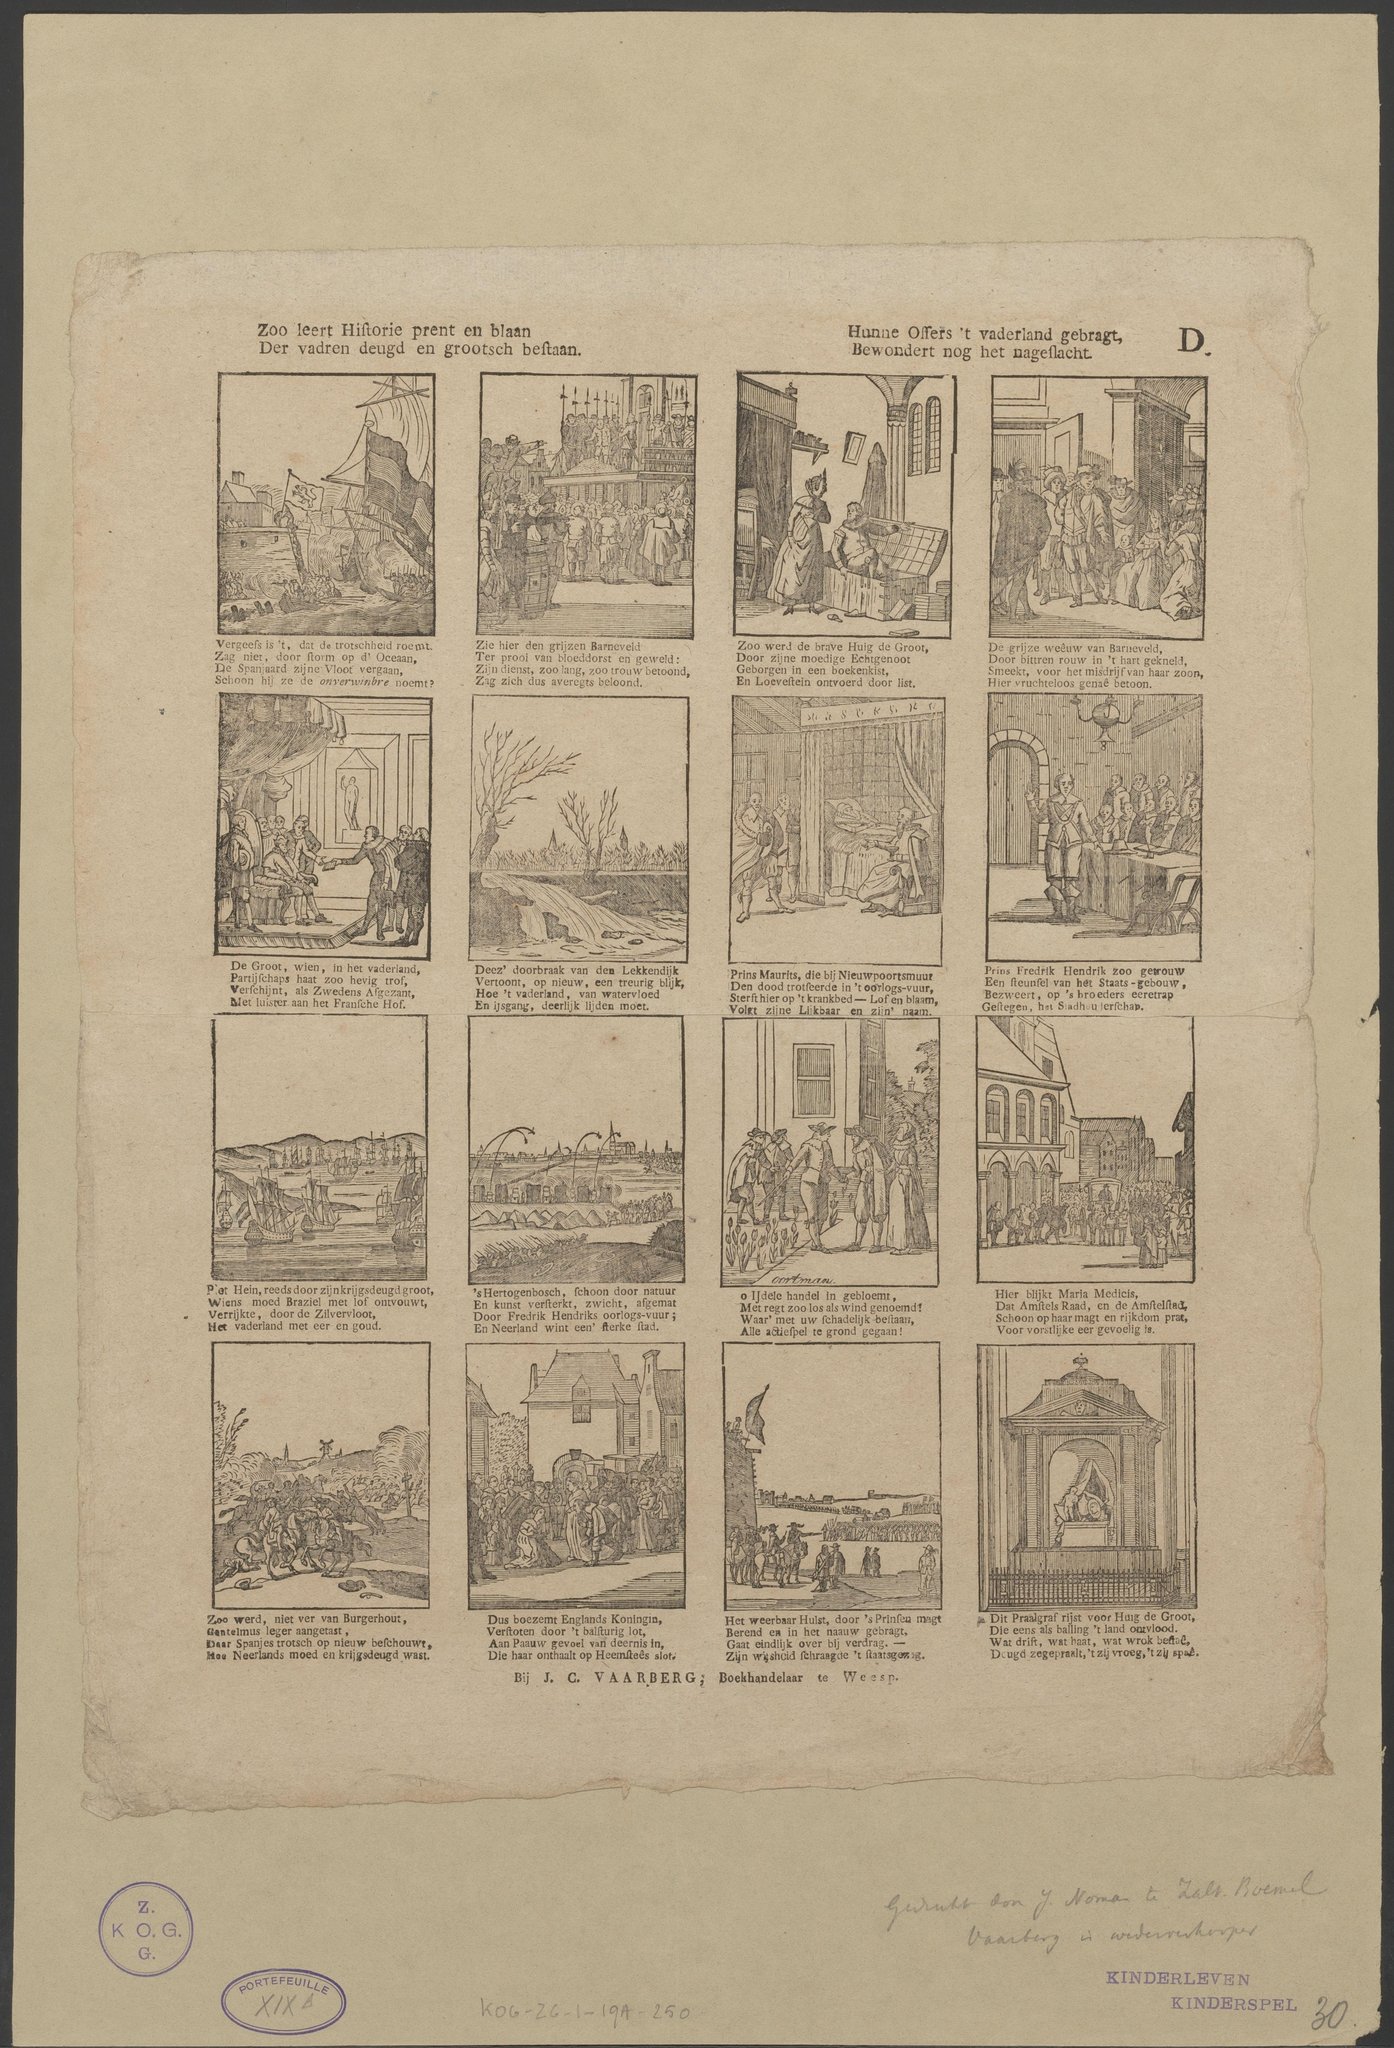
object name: popular print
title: Gebeurtenissen uit de vaderlandse geschiedenis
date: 1806-1830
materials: paper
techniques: letterpress printing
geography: weesp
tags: delft, hugo de groot, johan van oldenbarnevelt, delfshaven, frederick henry (prince of orange), the hague, maurice (prince of orange), cologne, print maker, maria de' medici, politics, loevestein castle, den bosch, low countries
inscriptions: stamp, stamp, collector's mark: Lugt 1641, watermark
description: Blad met zestien voorstellingen van gebeurtenissen uit de vaderlandse geschiedenis, zoals Hugo de Groot die ontsnapt uit Slot Loevestein in een boekenkist en de dood van Maurits. Onder elke afbeelding een vierregelig vers. Gemerkt rechtsboven: D. Onderwerpsrubrieken binnen de Atlas Zeden en Gewoonten: Zeden en Gewoonten in Engeren Zin, Des menschen beging, midden en einde, Kinderleven – Kinderspel en Kinderprenten.